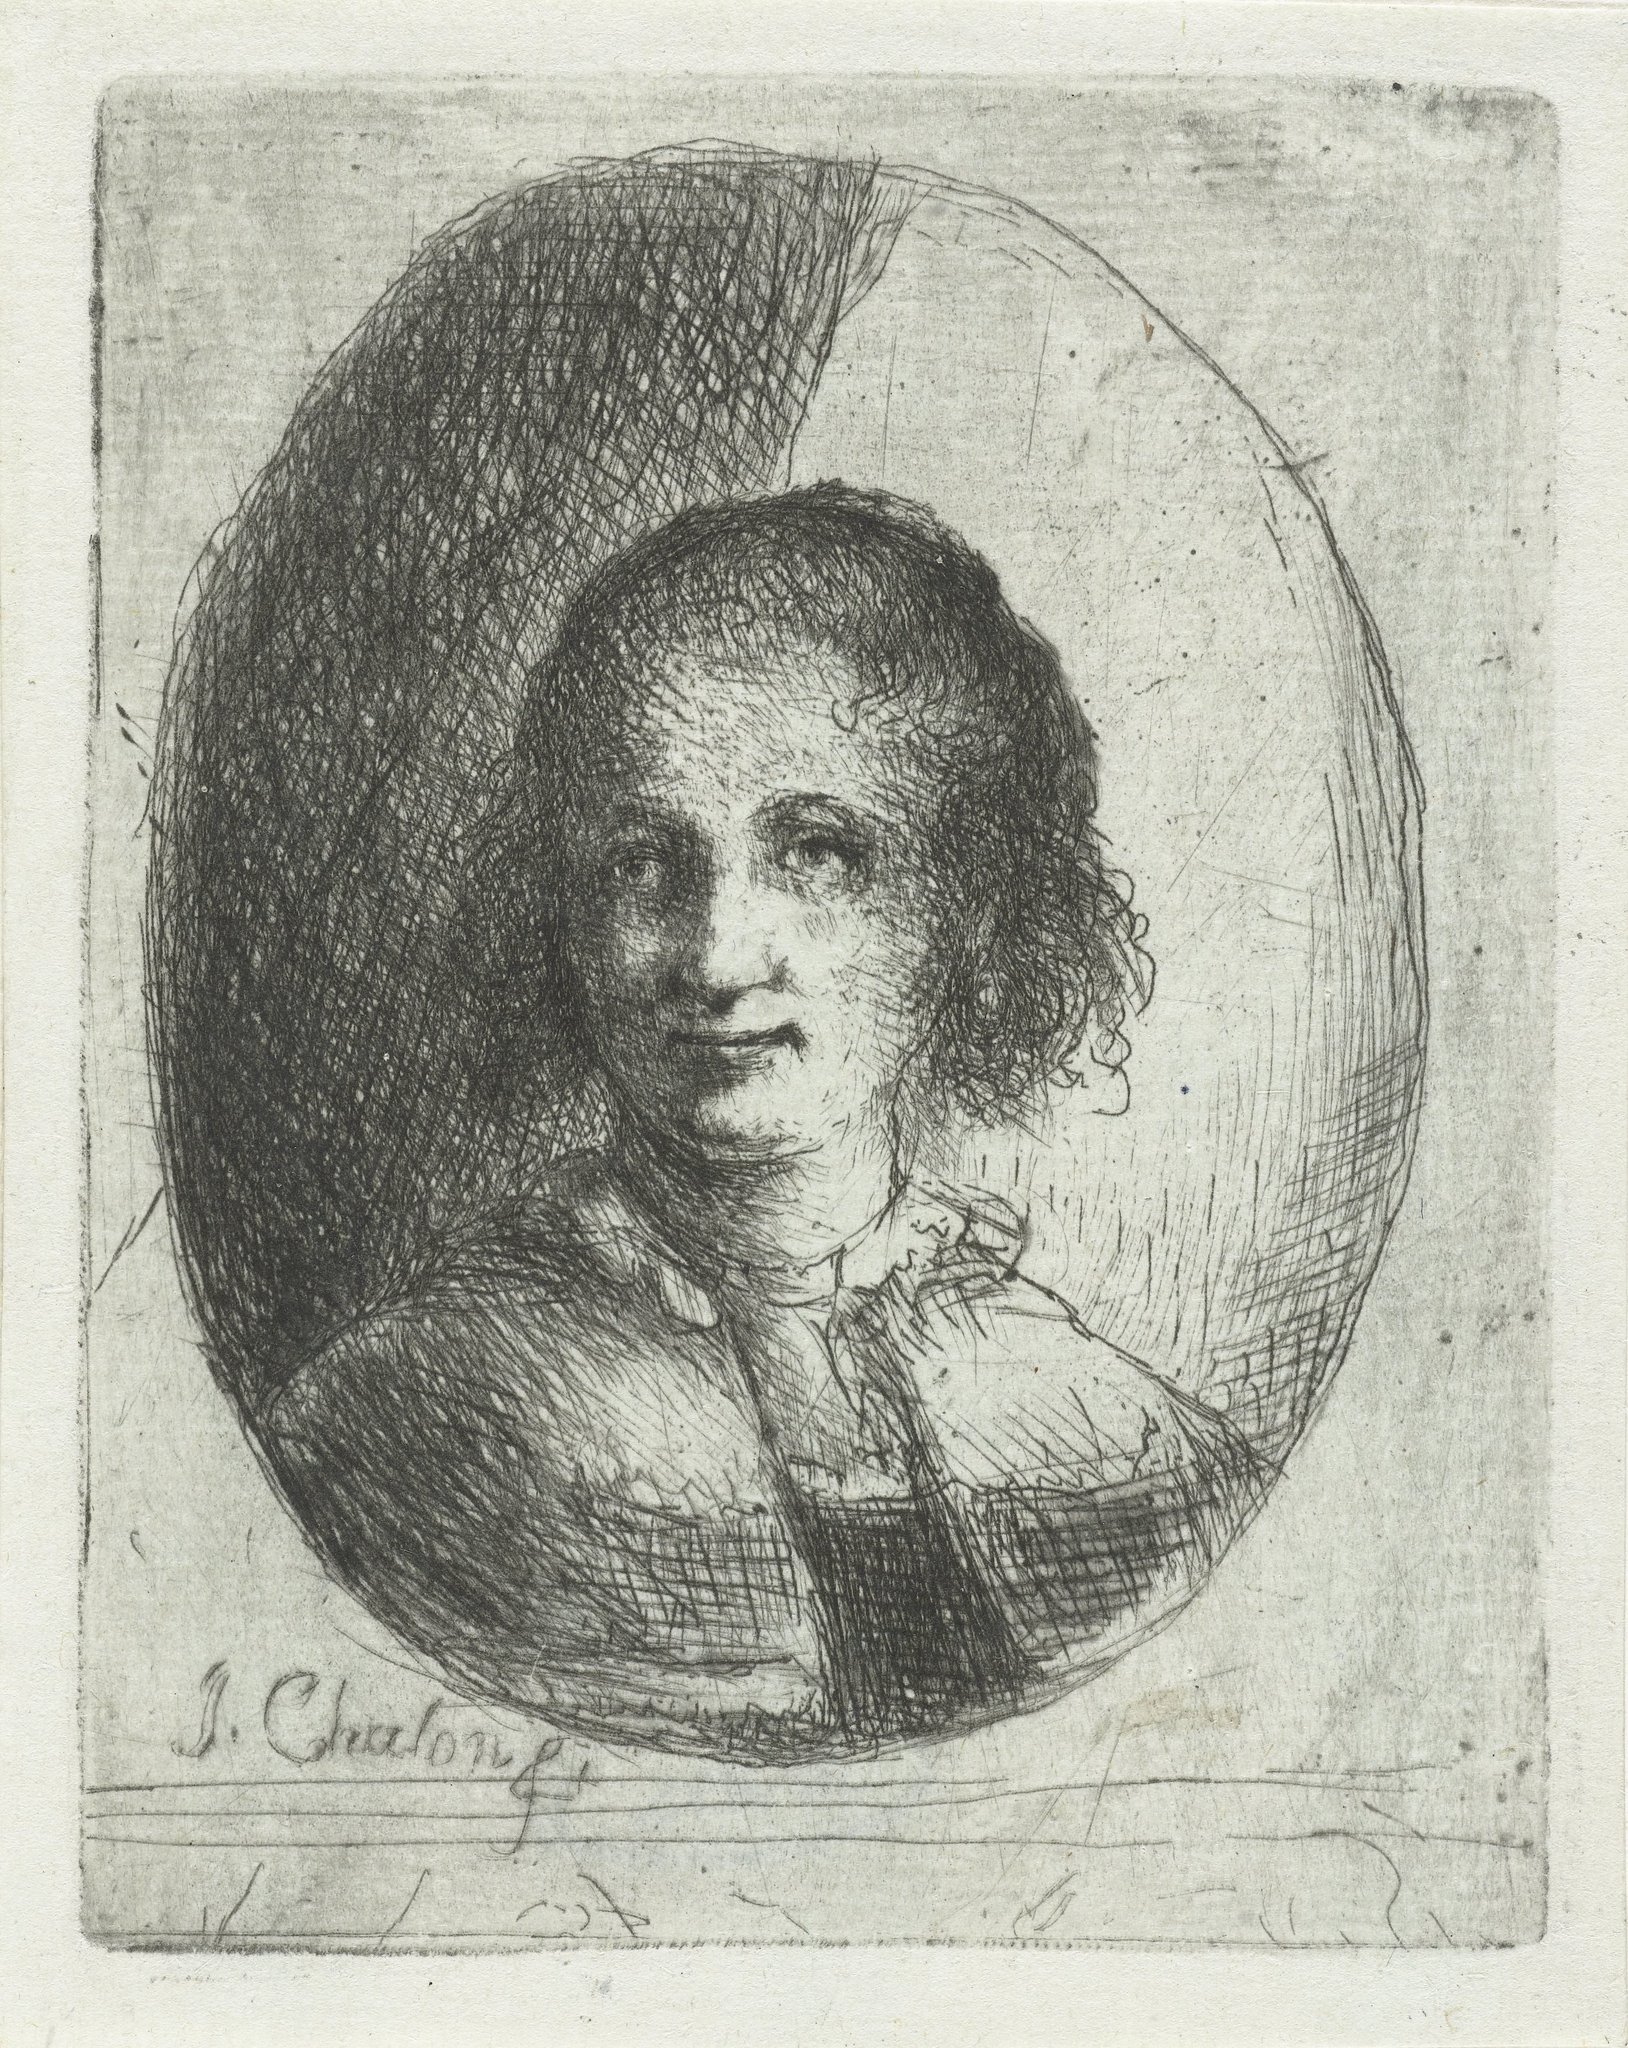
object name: print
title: Portret van Christina Chalon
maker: jan chalon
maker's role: print maker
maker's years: 1738-1795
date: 1748-1795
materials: paper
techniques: drypoint, etching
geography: northern netherlands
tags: amsterdam, leiden, print maker, draughtsman, christina chalon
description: Portret in ovale lijst van Christina Chalon, prentmaakster en zus van Jan Chalon. Buste en face, iets naar links.